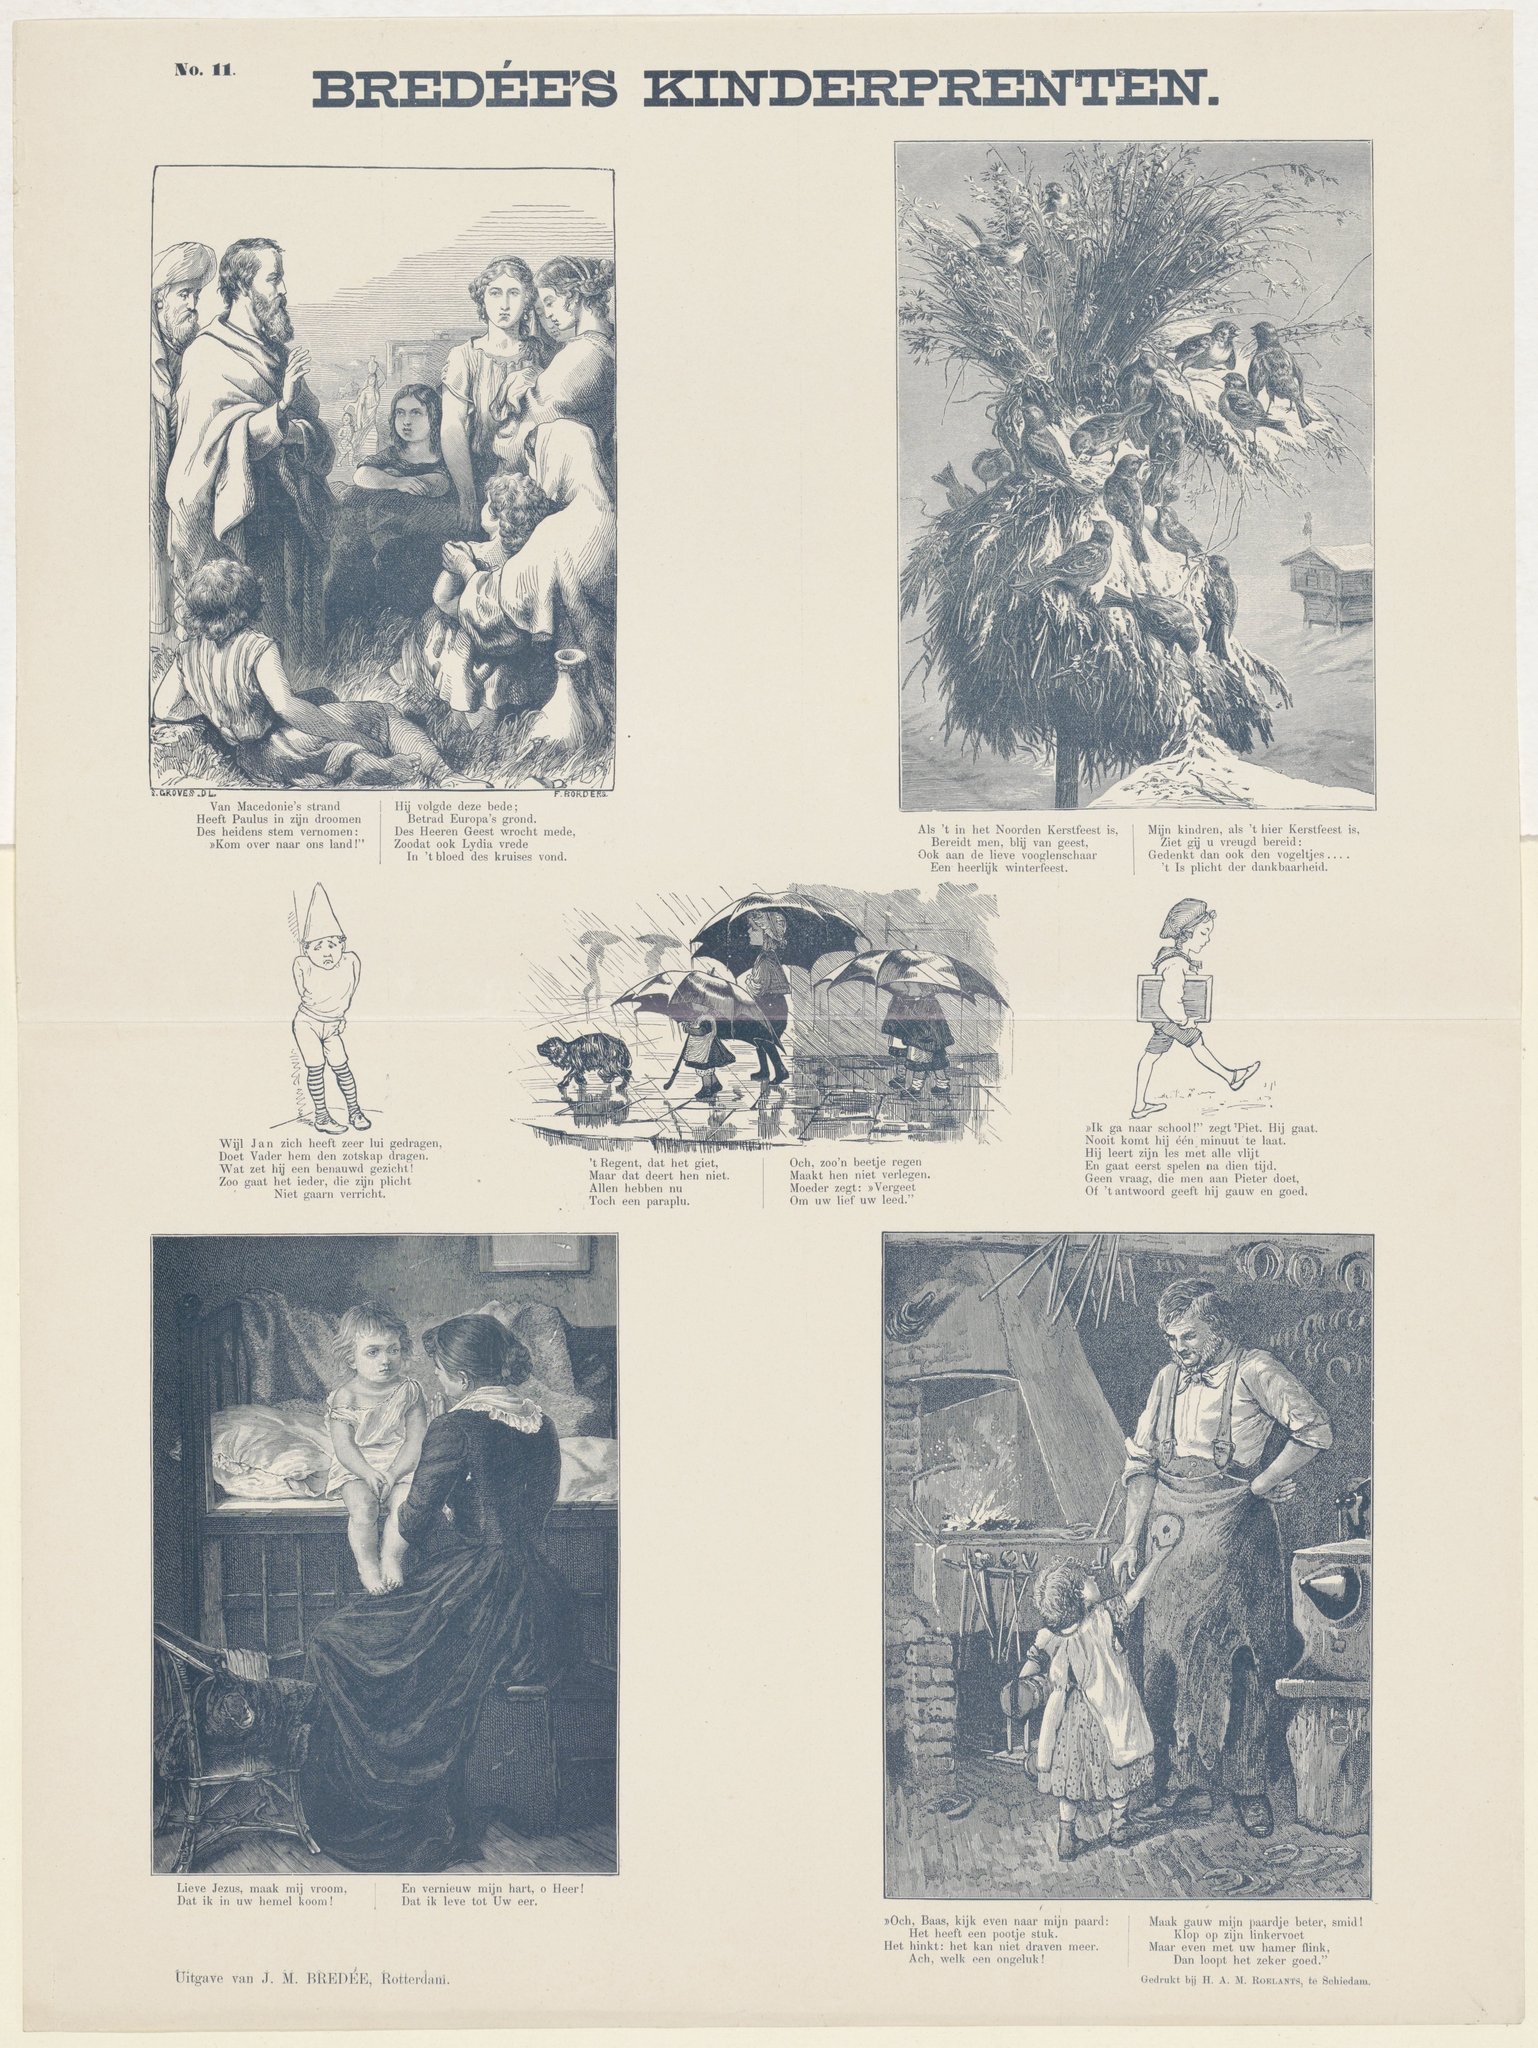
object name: print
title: Verschillende voorstellingen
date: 1894-1918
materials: paper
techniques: letterpress printing, line block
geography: rotterdam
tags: correction of naughty children, birds, umbrella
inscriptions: collector's mark: Lugt 2760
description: Blad met 7 voorstellingen van verschillende aard, zoals voorstellingen van Jan die voor staf in de hoek staat met een puntmuts op zijn hoofd, kinderen die met paraplu's door de regen lopen en van een nest met vogels. Onder elke afbeelding vier tot acht regels vers. Genummerd linksboven: No. 11.